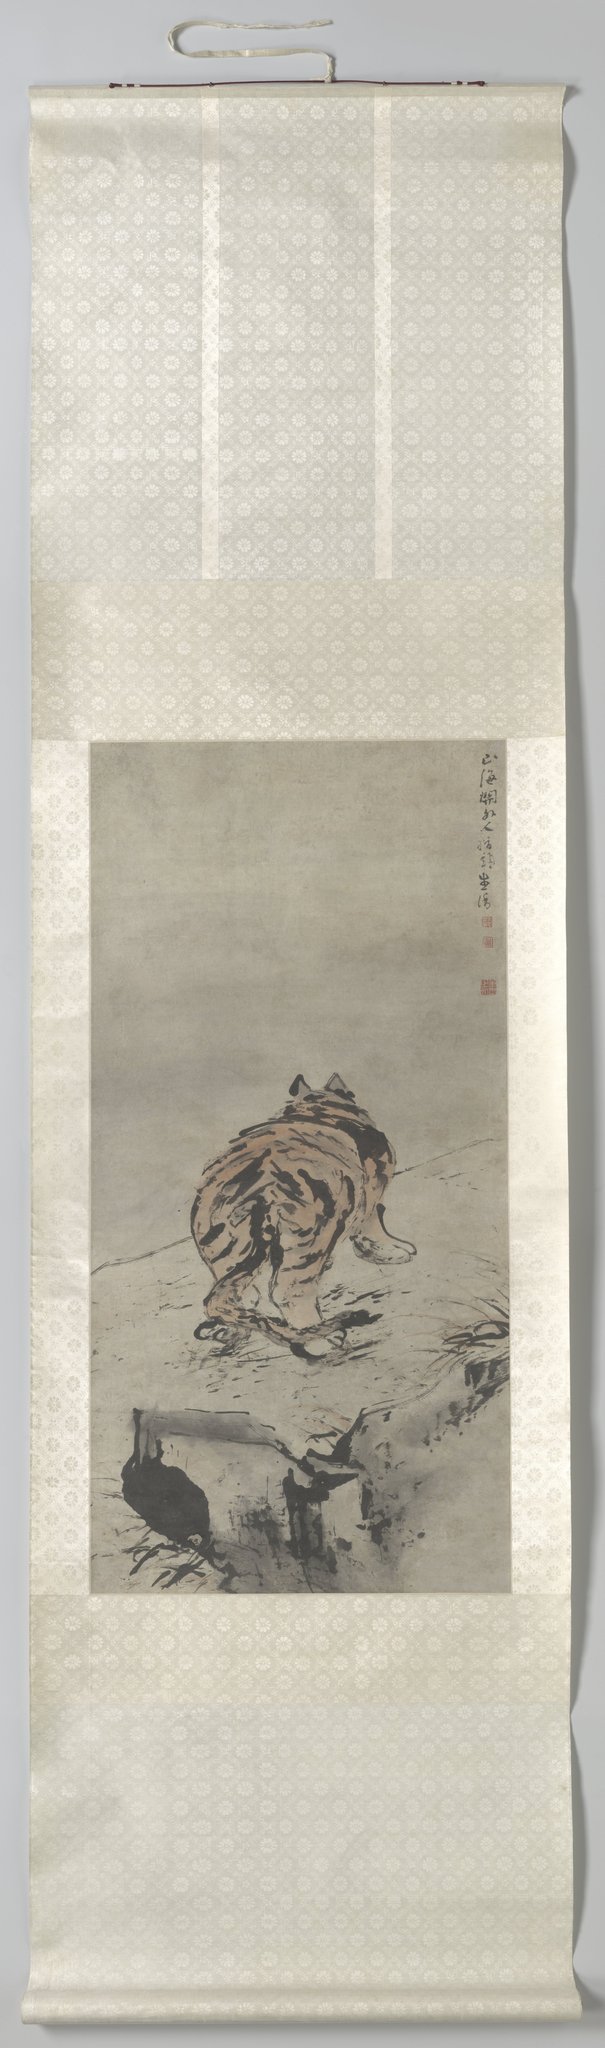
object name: hanging scroll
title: Tiger Seen from the Rear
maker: gao qipei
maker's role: painter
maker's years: 1661-1734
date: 1700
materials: ink, paper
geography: tieling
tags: beasts of prey, predatory animals: tiger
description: Tiger. China, c. 1700. Gao Qipei (1660-1734). Colours and ink on paper. Tigers were favourite theme of the eccentric painter Gao Qipei. Here he depicts a tiger in an uncharacteristic pose: a tired, shabby animal, quite unaware that anyone has managed to get this close.